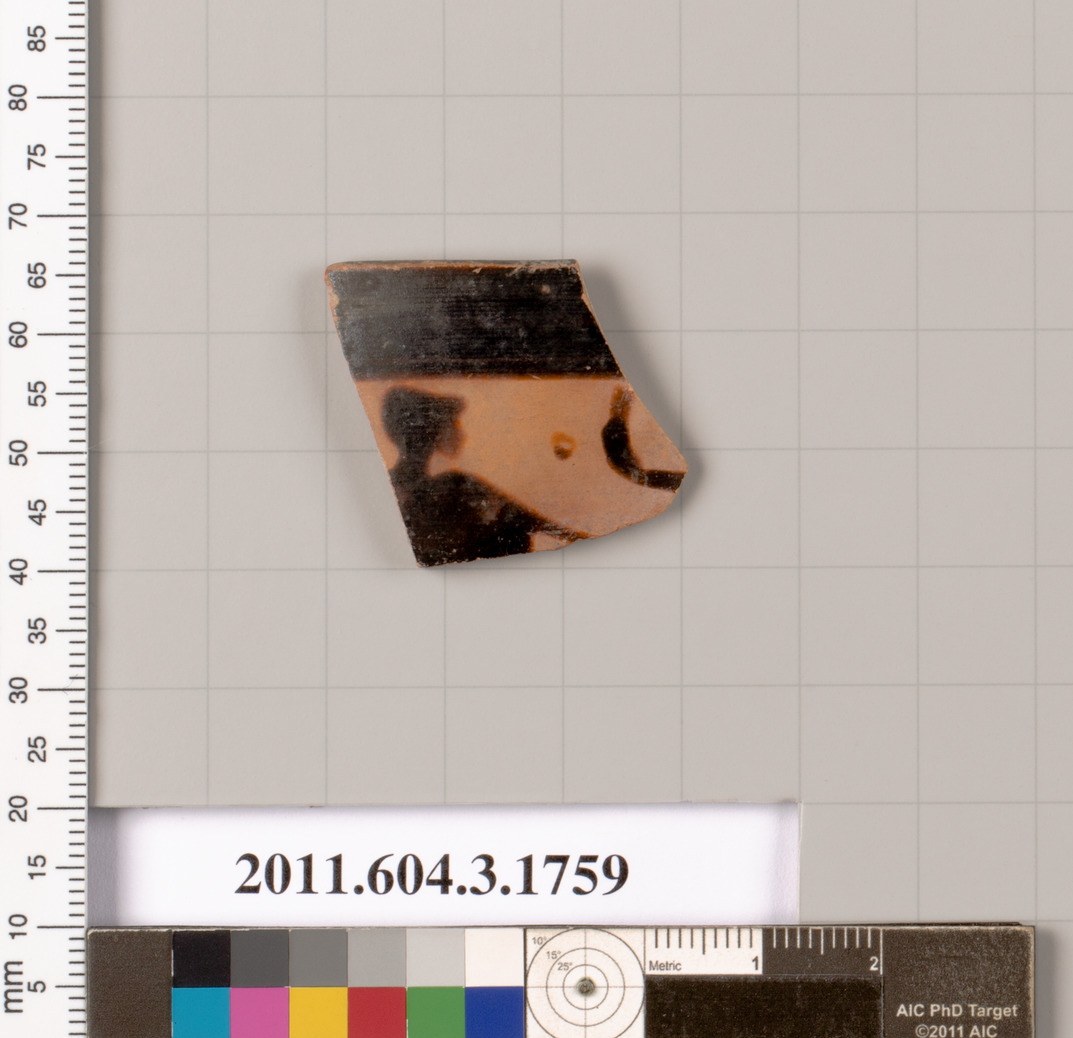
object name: kylix fragment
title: Terracotta rim fragment of a kylix: Band cup (drinking cup)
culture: greek, attic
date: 525-501 BCE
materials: terracotta